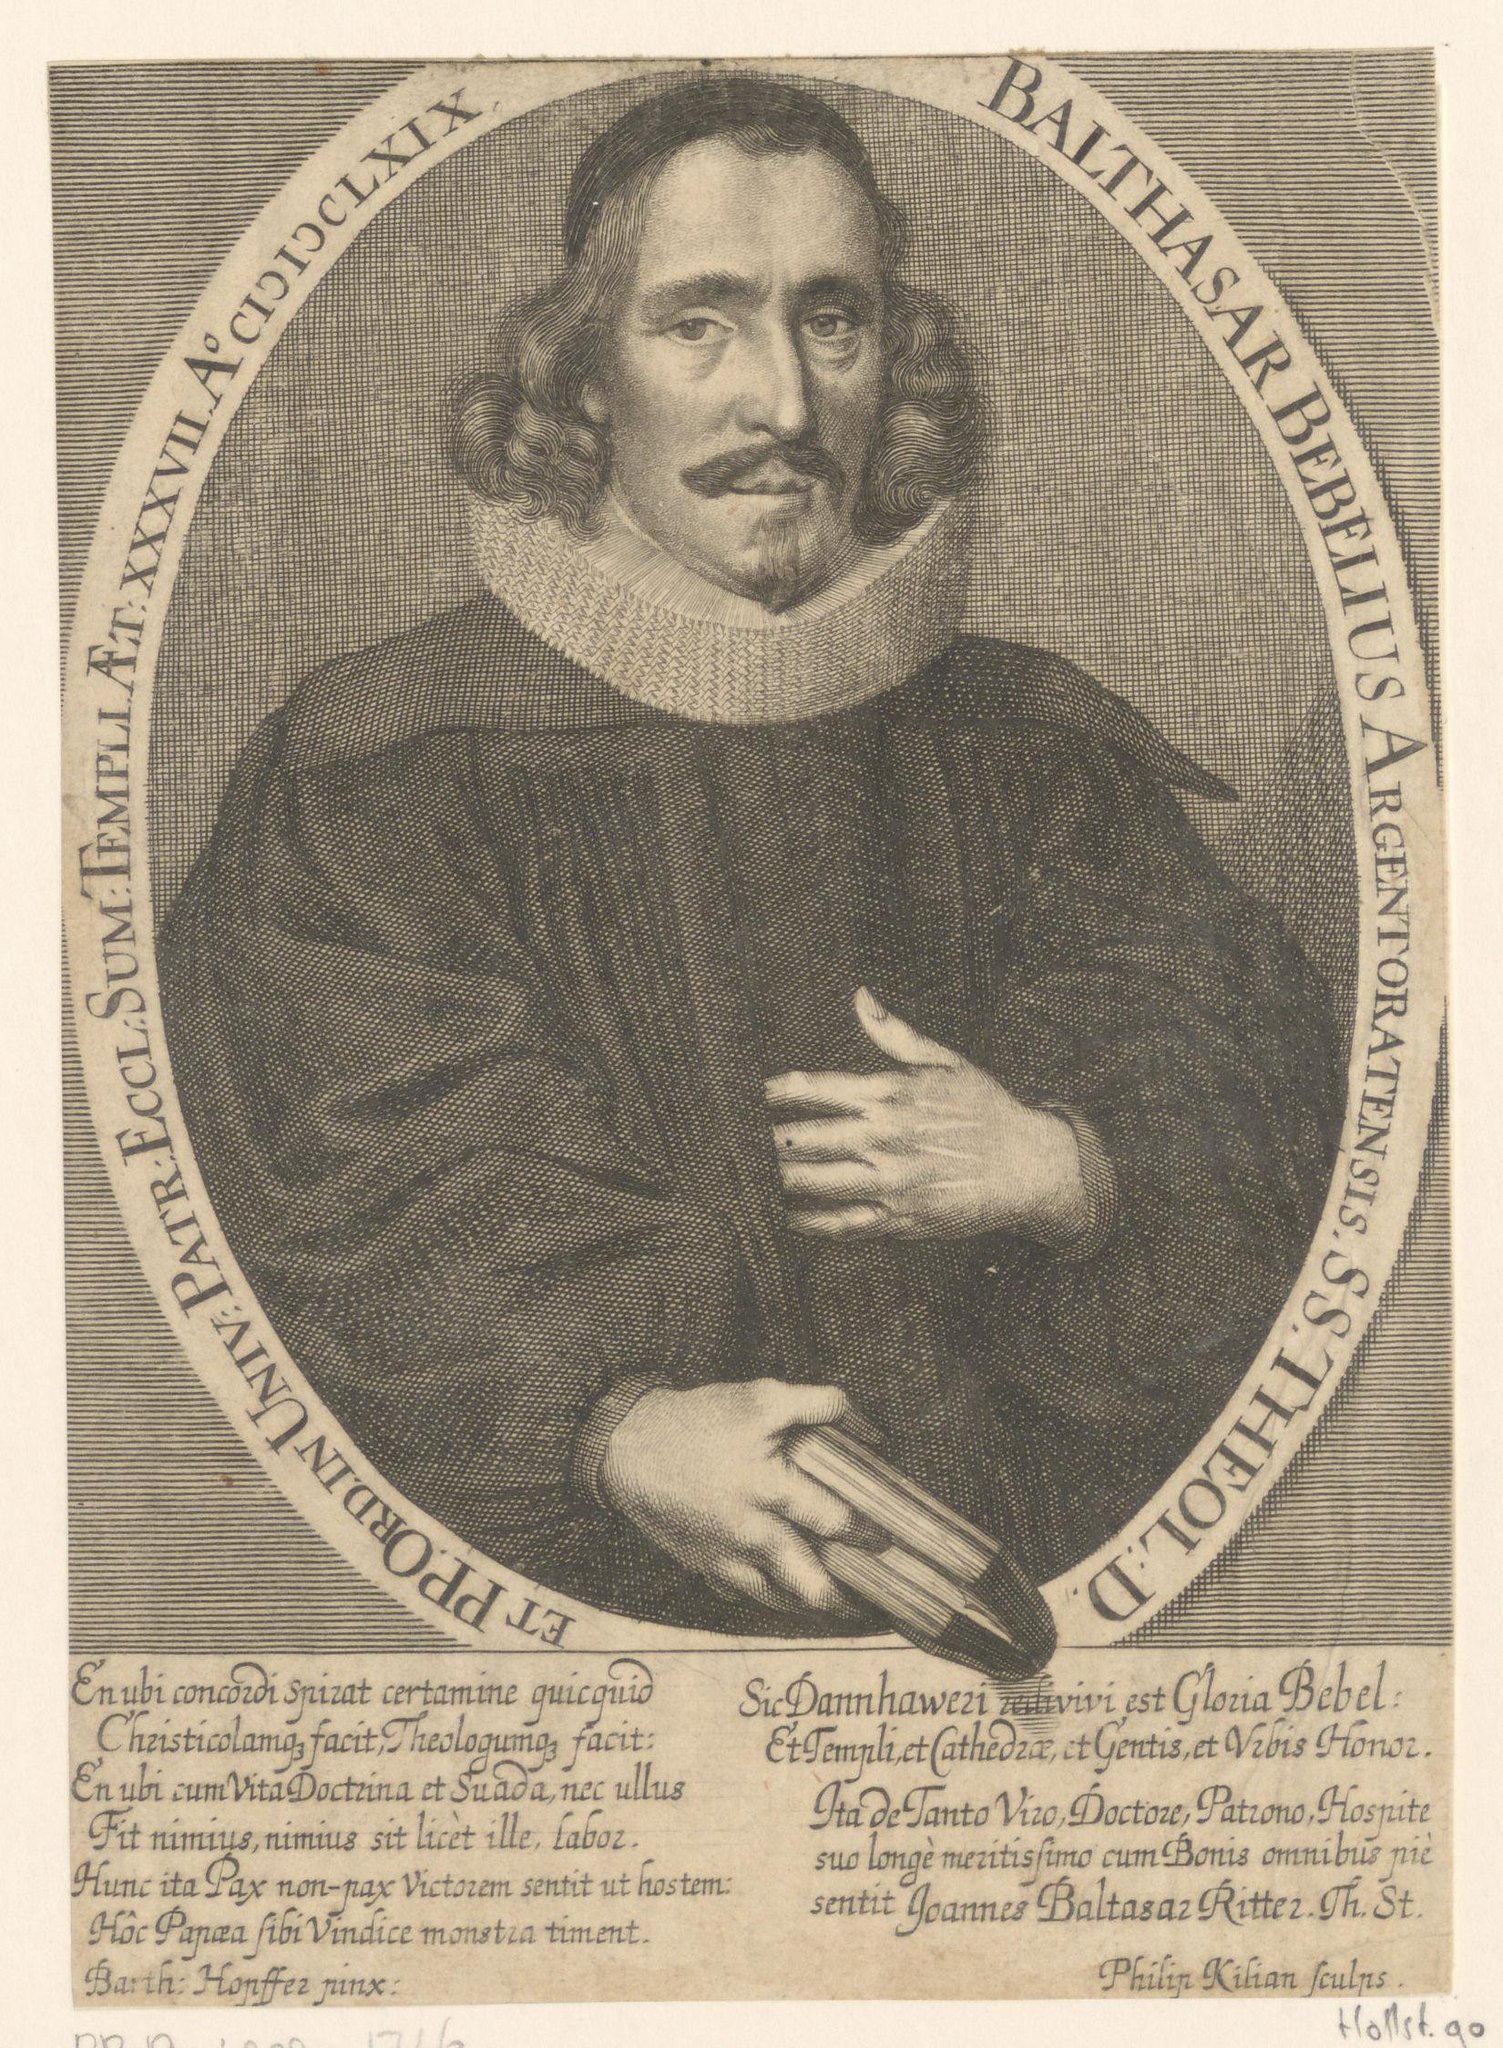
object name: print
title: Portret van Balthasar Bebel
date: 1669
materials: paper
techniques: engraving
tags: balthasar bebel, theologian, further education (+ portrait of teacher, professor), historical persons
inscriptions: collector's mark: Lugt 2228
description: Tekst in het Latijn in de omlijsting en in de ondermarge.